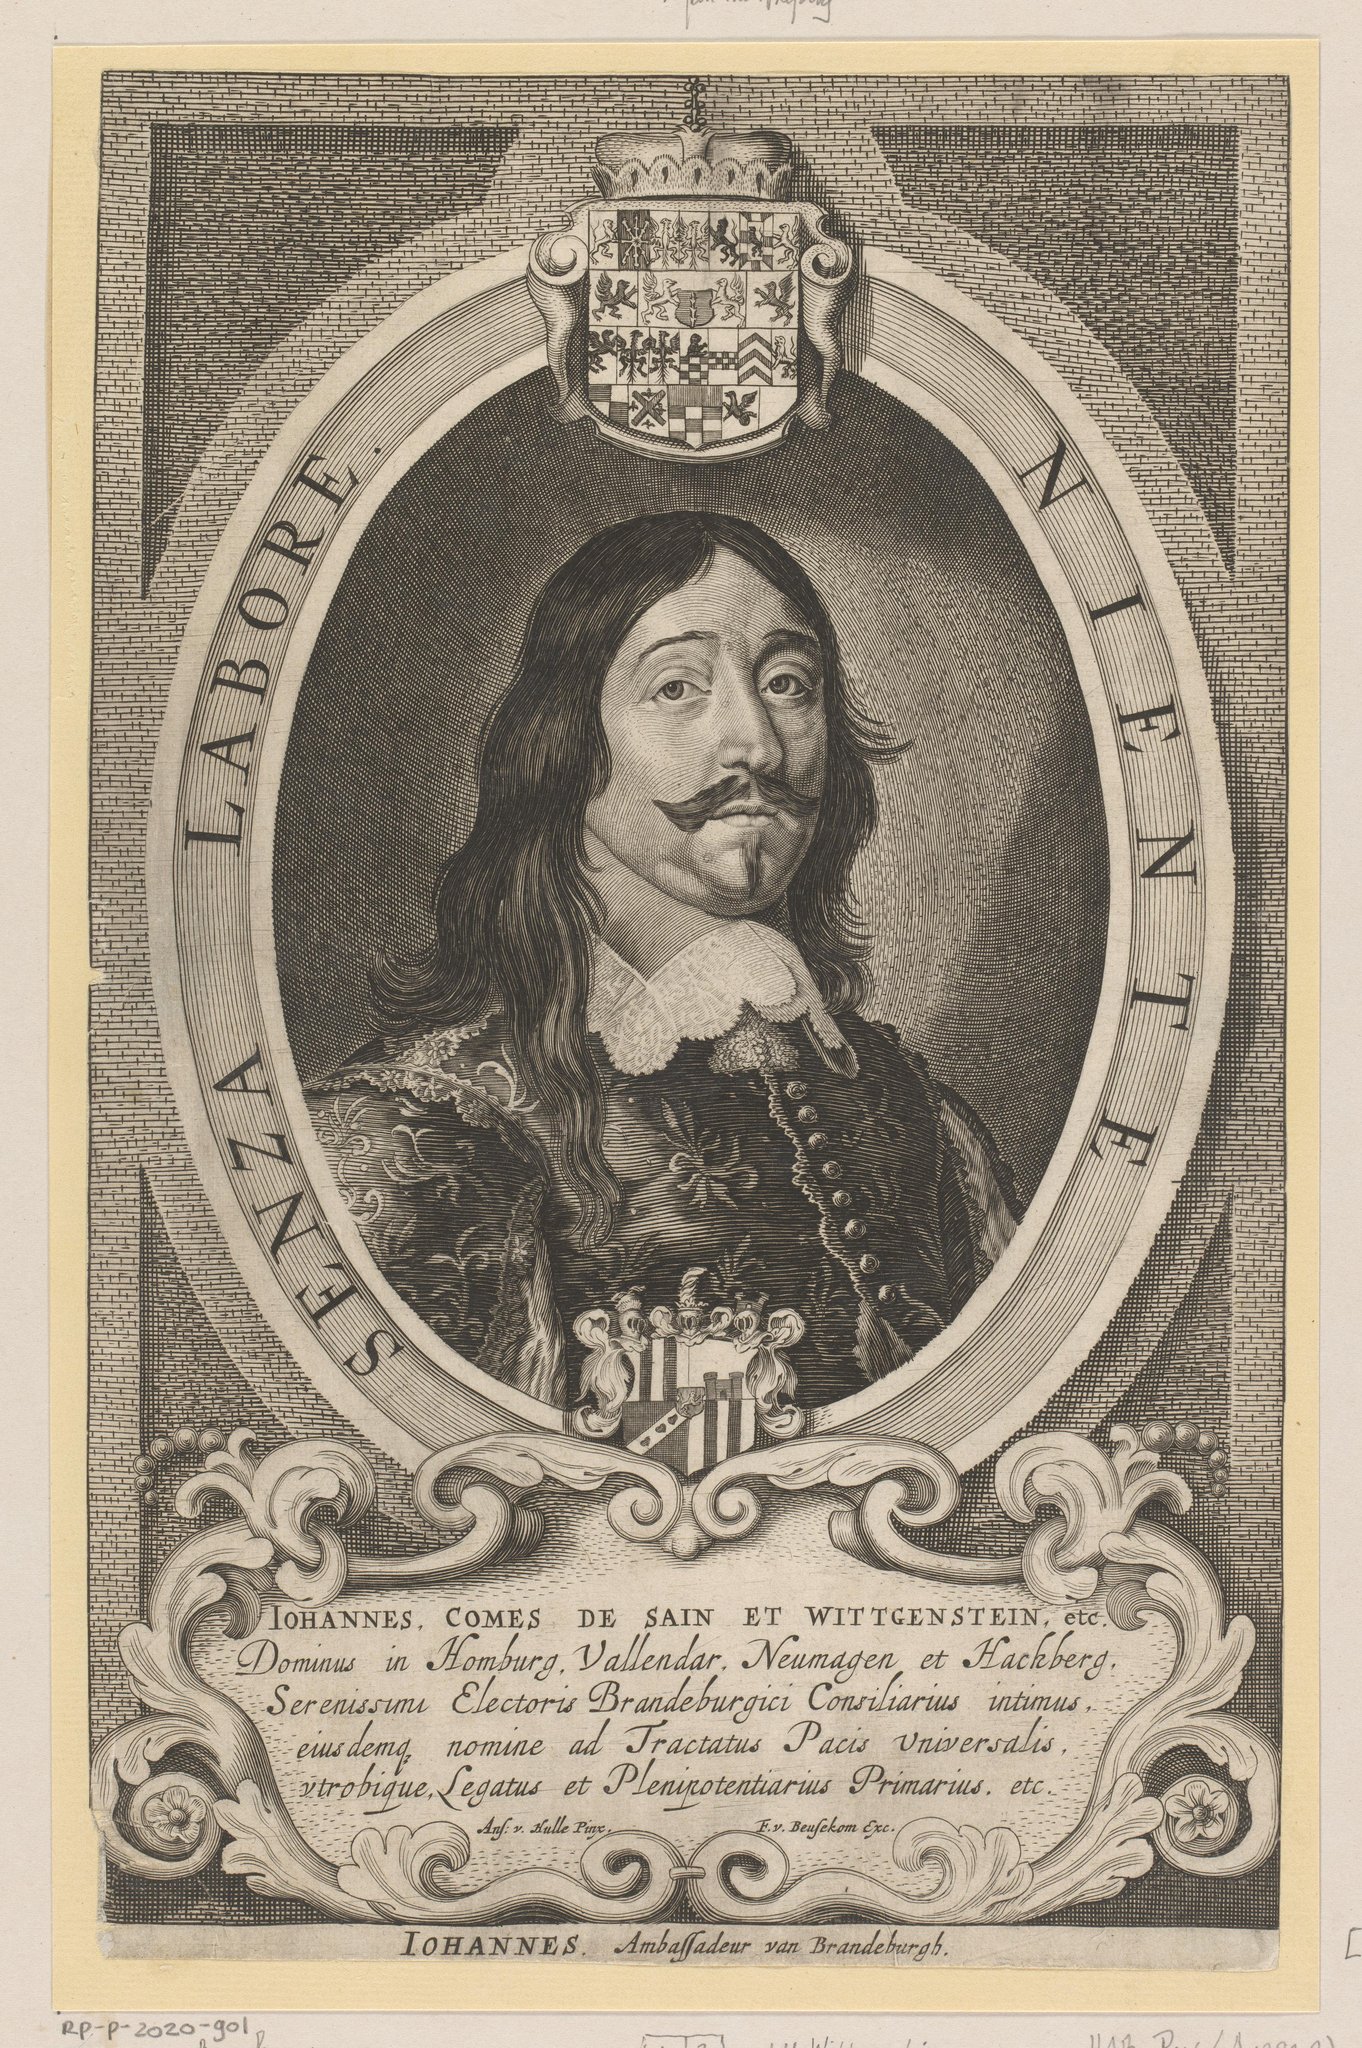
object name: print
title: Portret van Johannes VIII, graaf van Sayn-Wittgenstein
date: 1648-1665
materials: paper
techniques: engraving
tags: earl, historical persons, nobility and patriciate; chivalry, knighthood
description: Spiegelbeeldige kopie naar een prent van Cornelis Galle II. Zie documentatie. De prent maakt waarschijnlijk onderdeel uit van een serie portretten met vredesonderhandelaars die betrokken waren bij de Vrede van Münster.